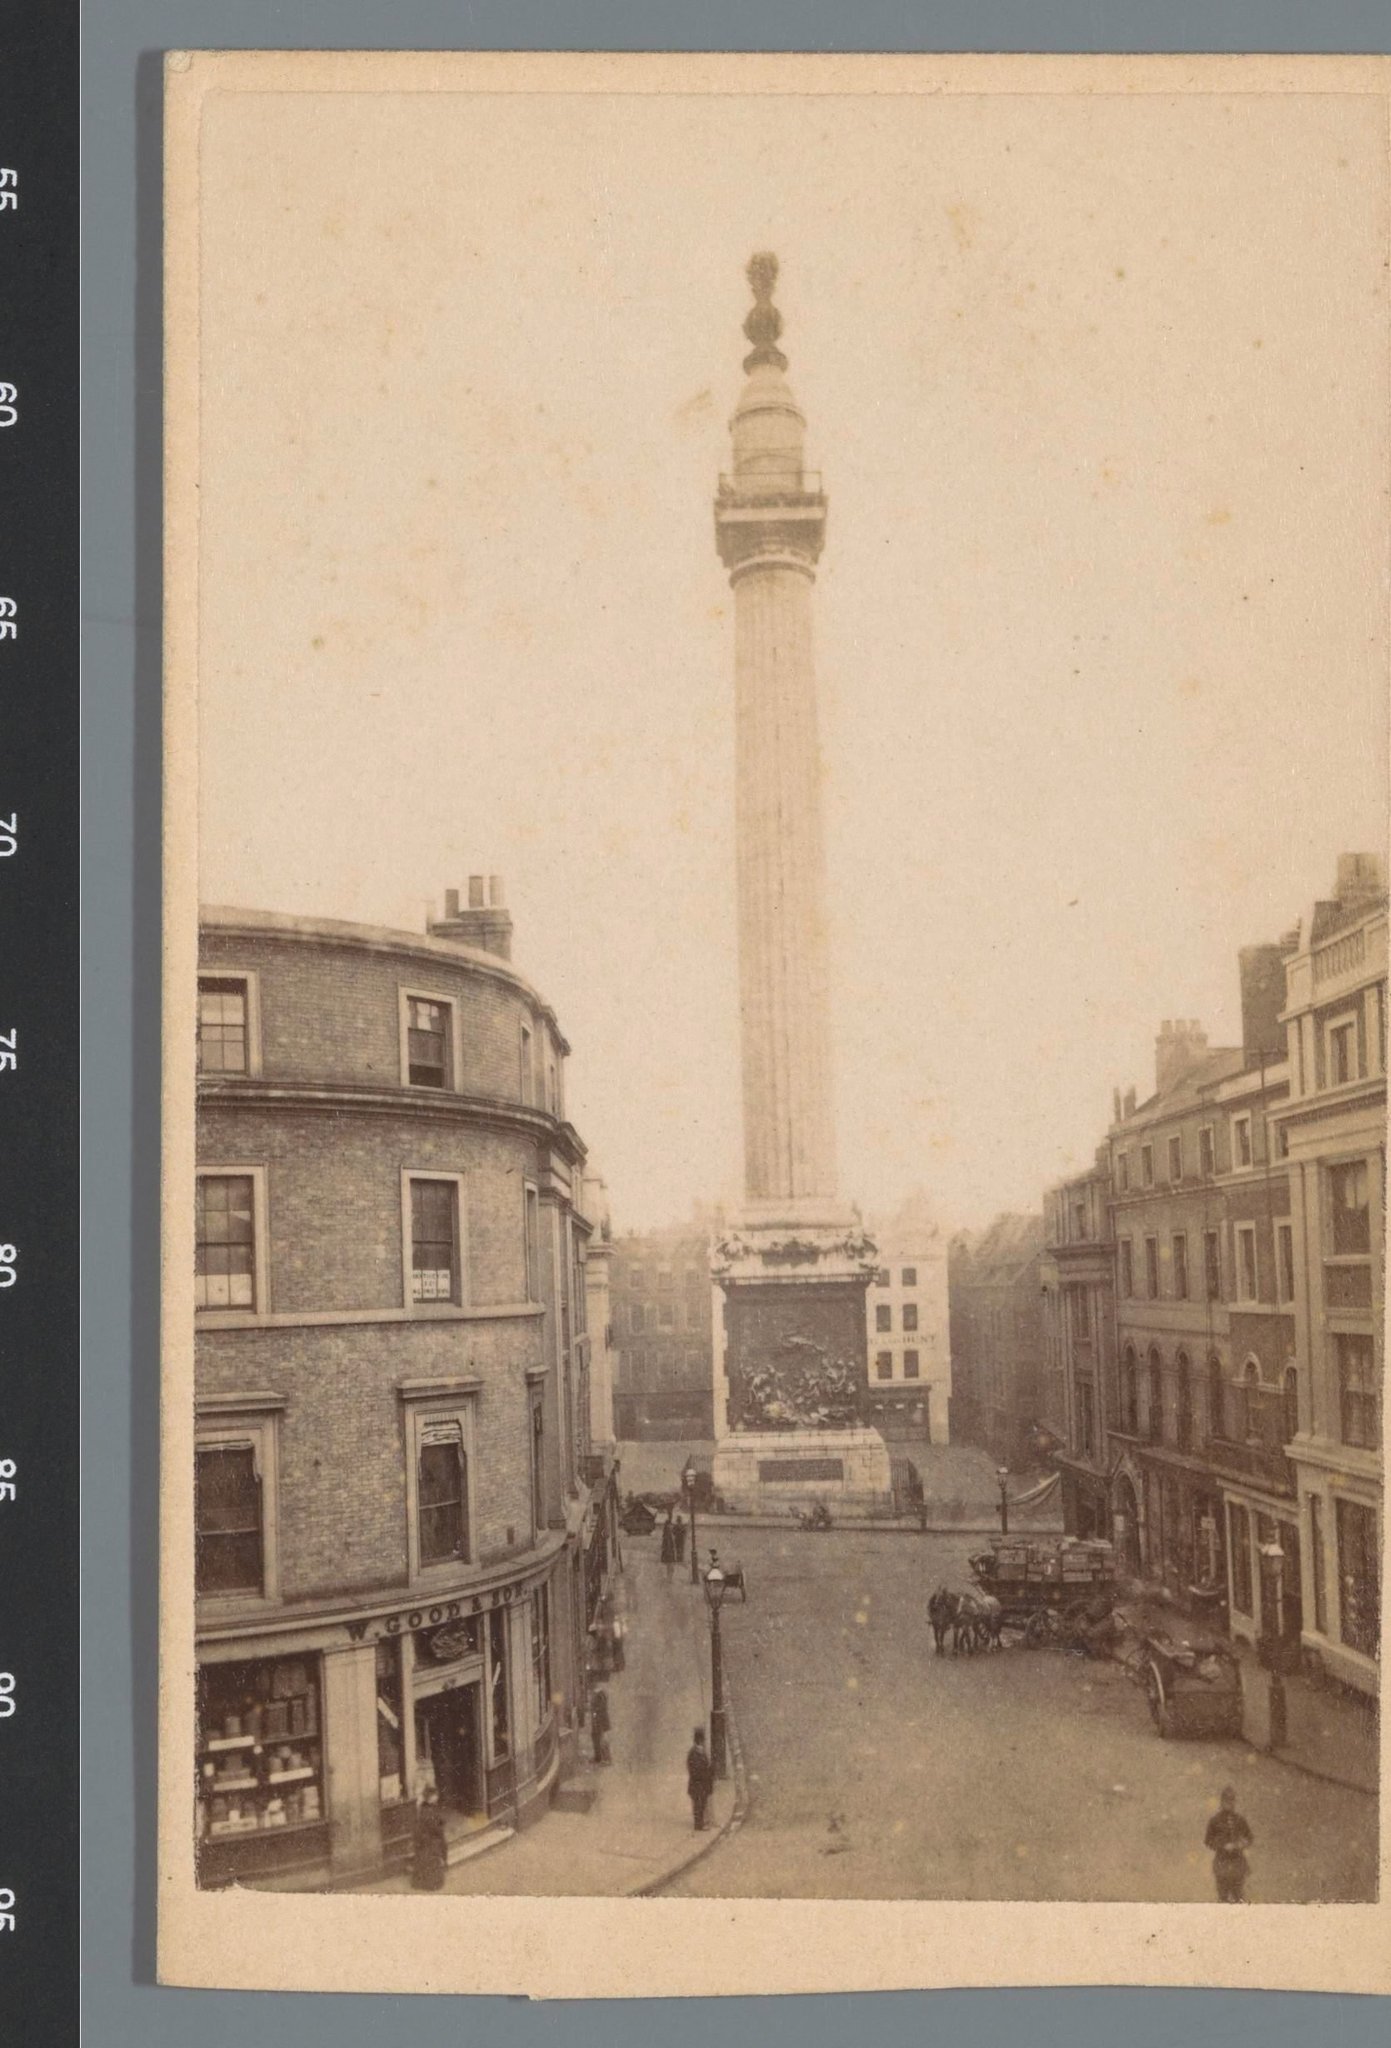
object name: photograph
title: Fire Monument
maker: Anonymous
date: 1855-1885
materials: cardboard, paper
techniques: albumen print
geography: london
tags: triumphal column with helical friezes